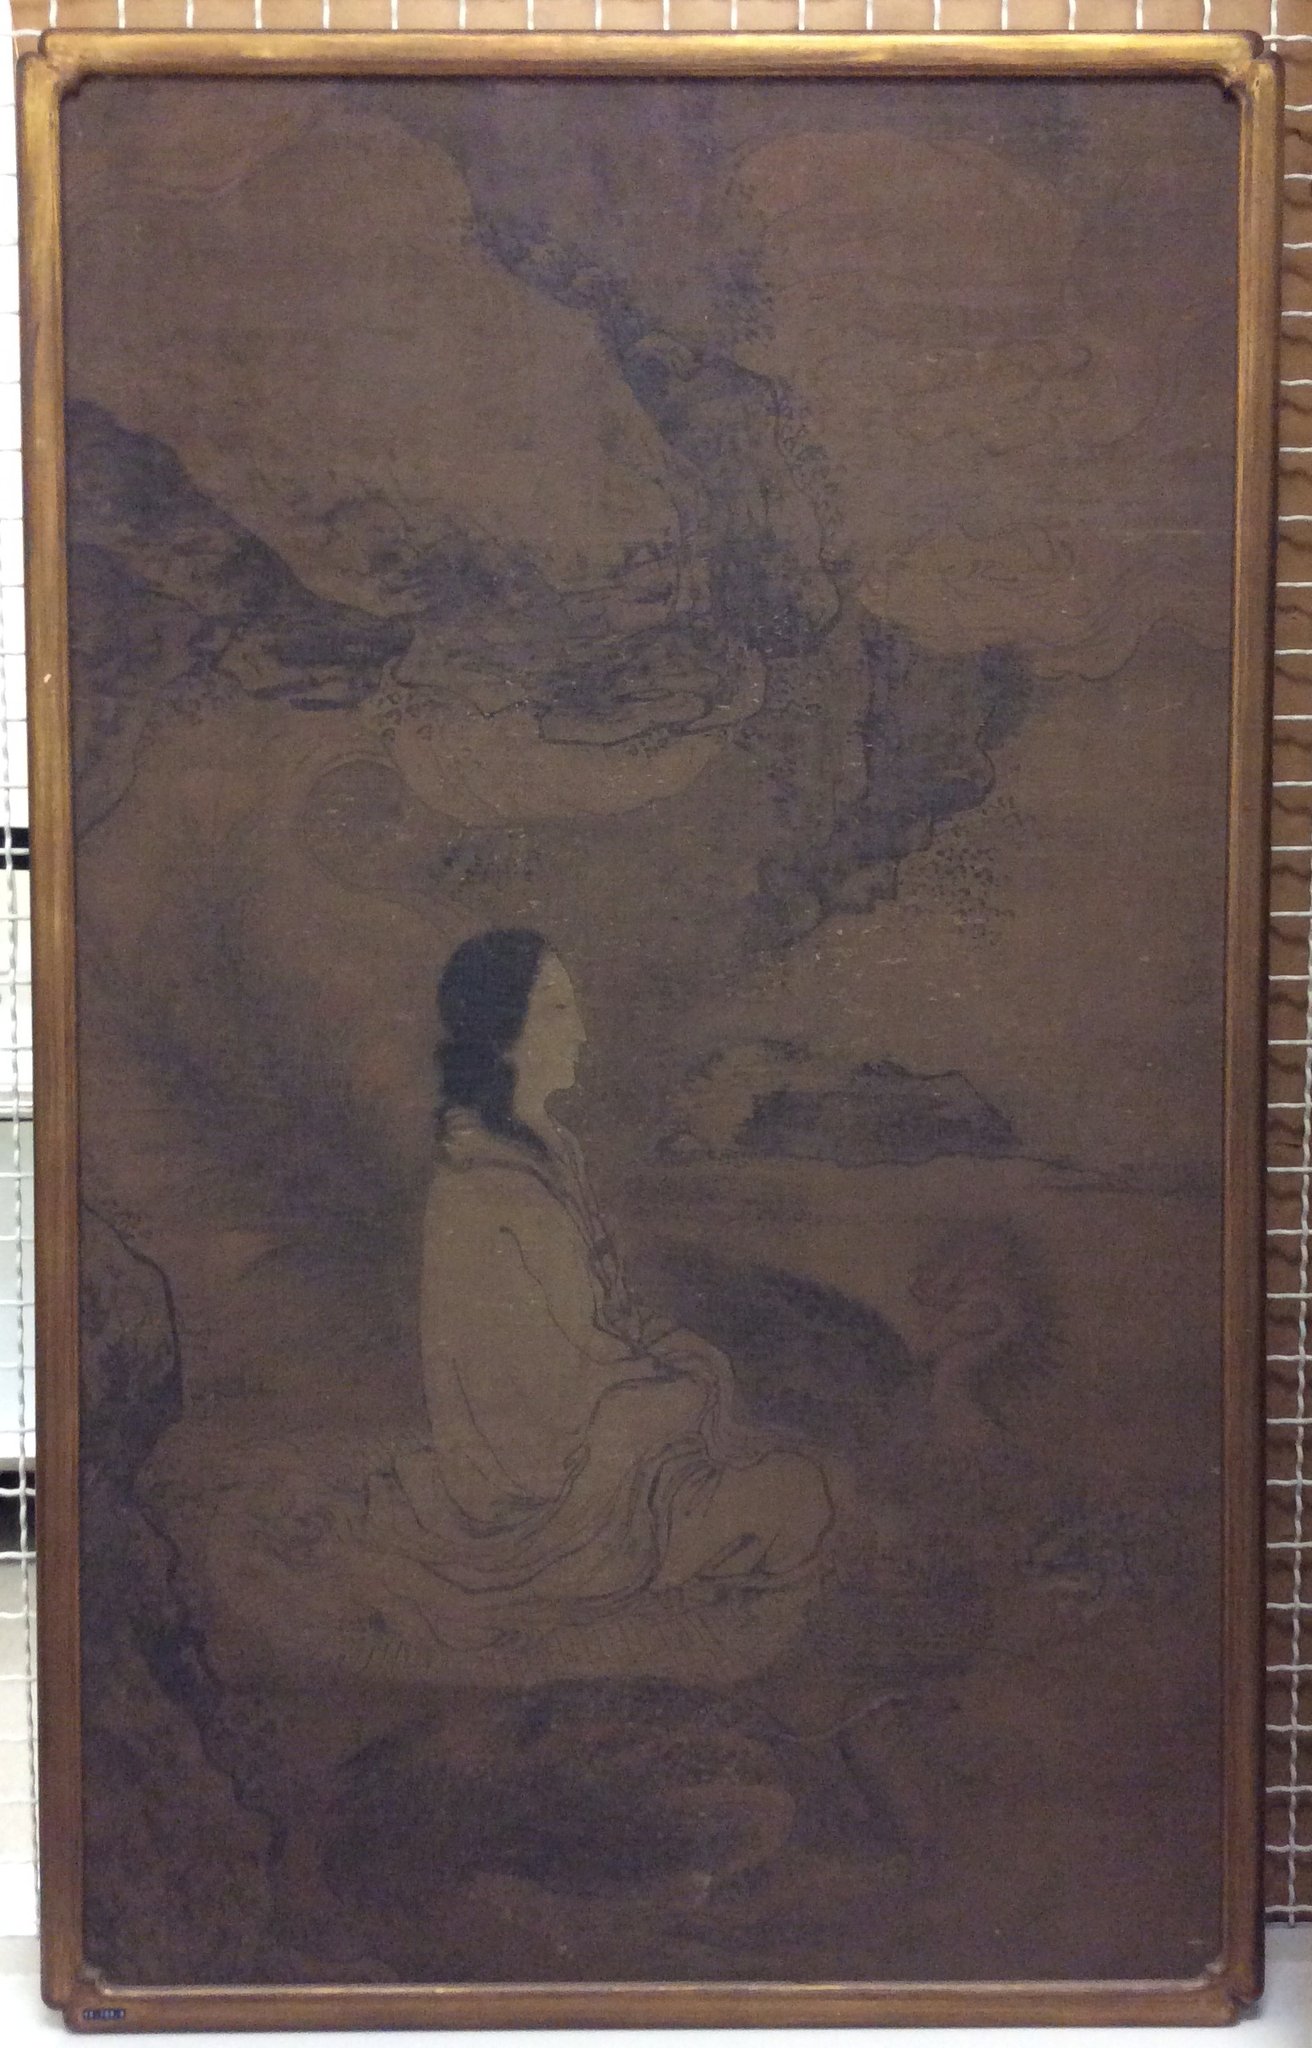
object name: hanging scroll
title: Xi Wang Mu with Feng Wang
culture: chinese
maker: jiang feng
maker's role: artist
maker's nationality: chinese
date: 1368-1911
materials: ink, silk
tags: women